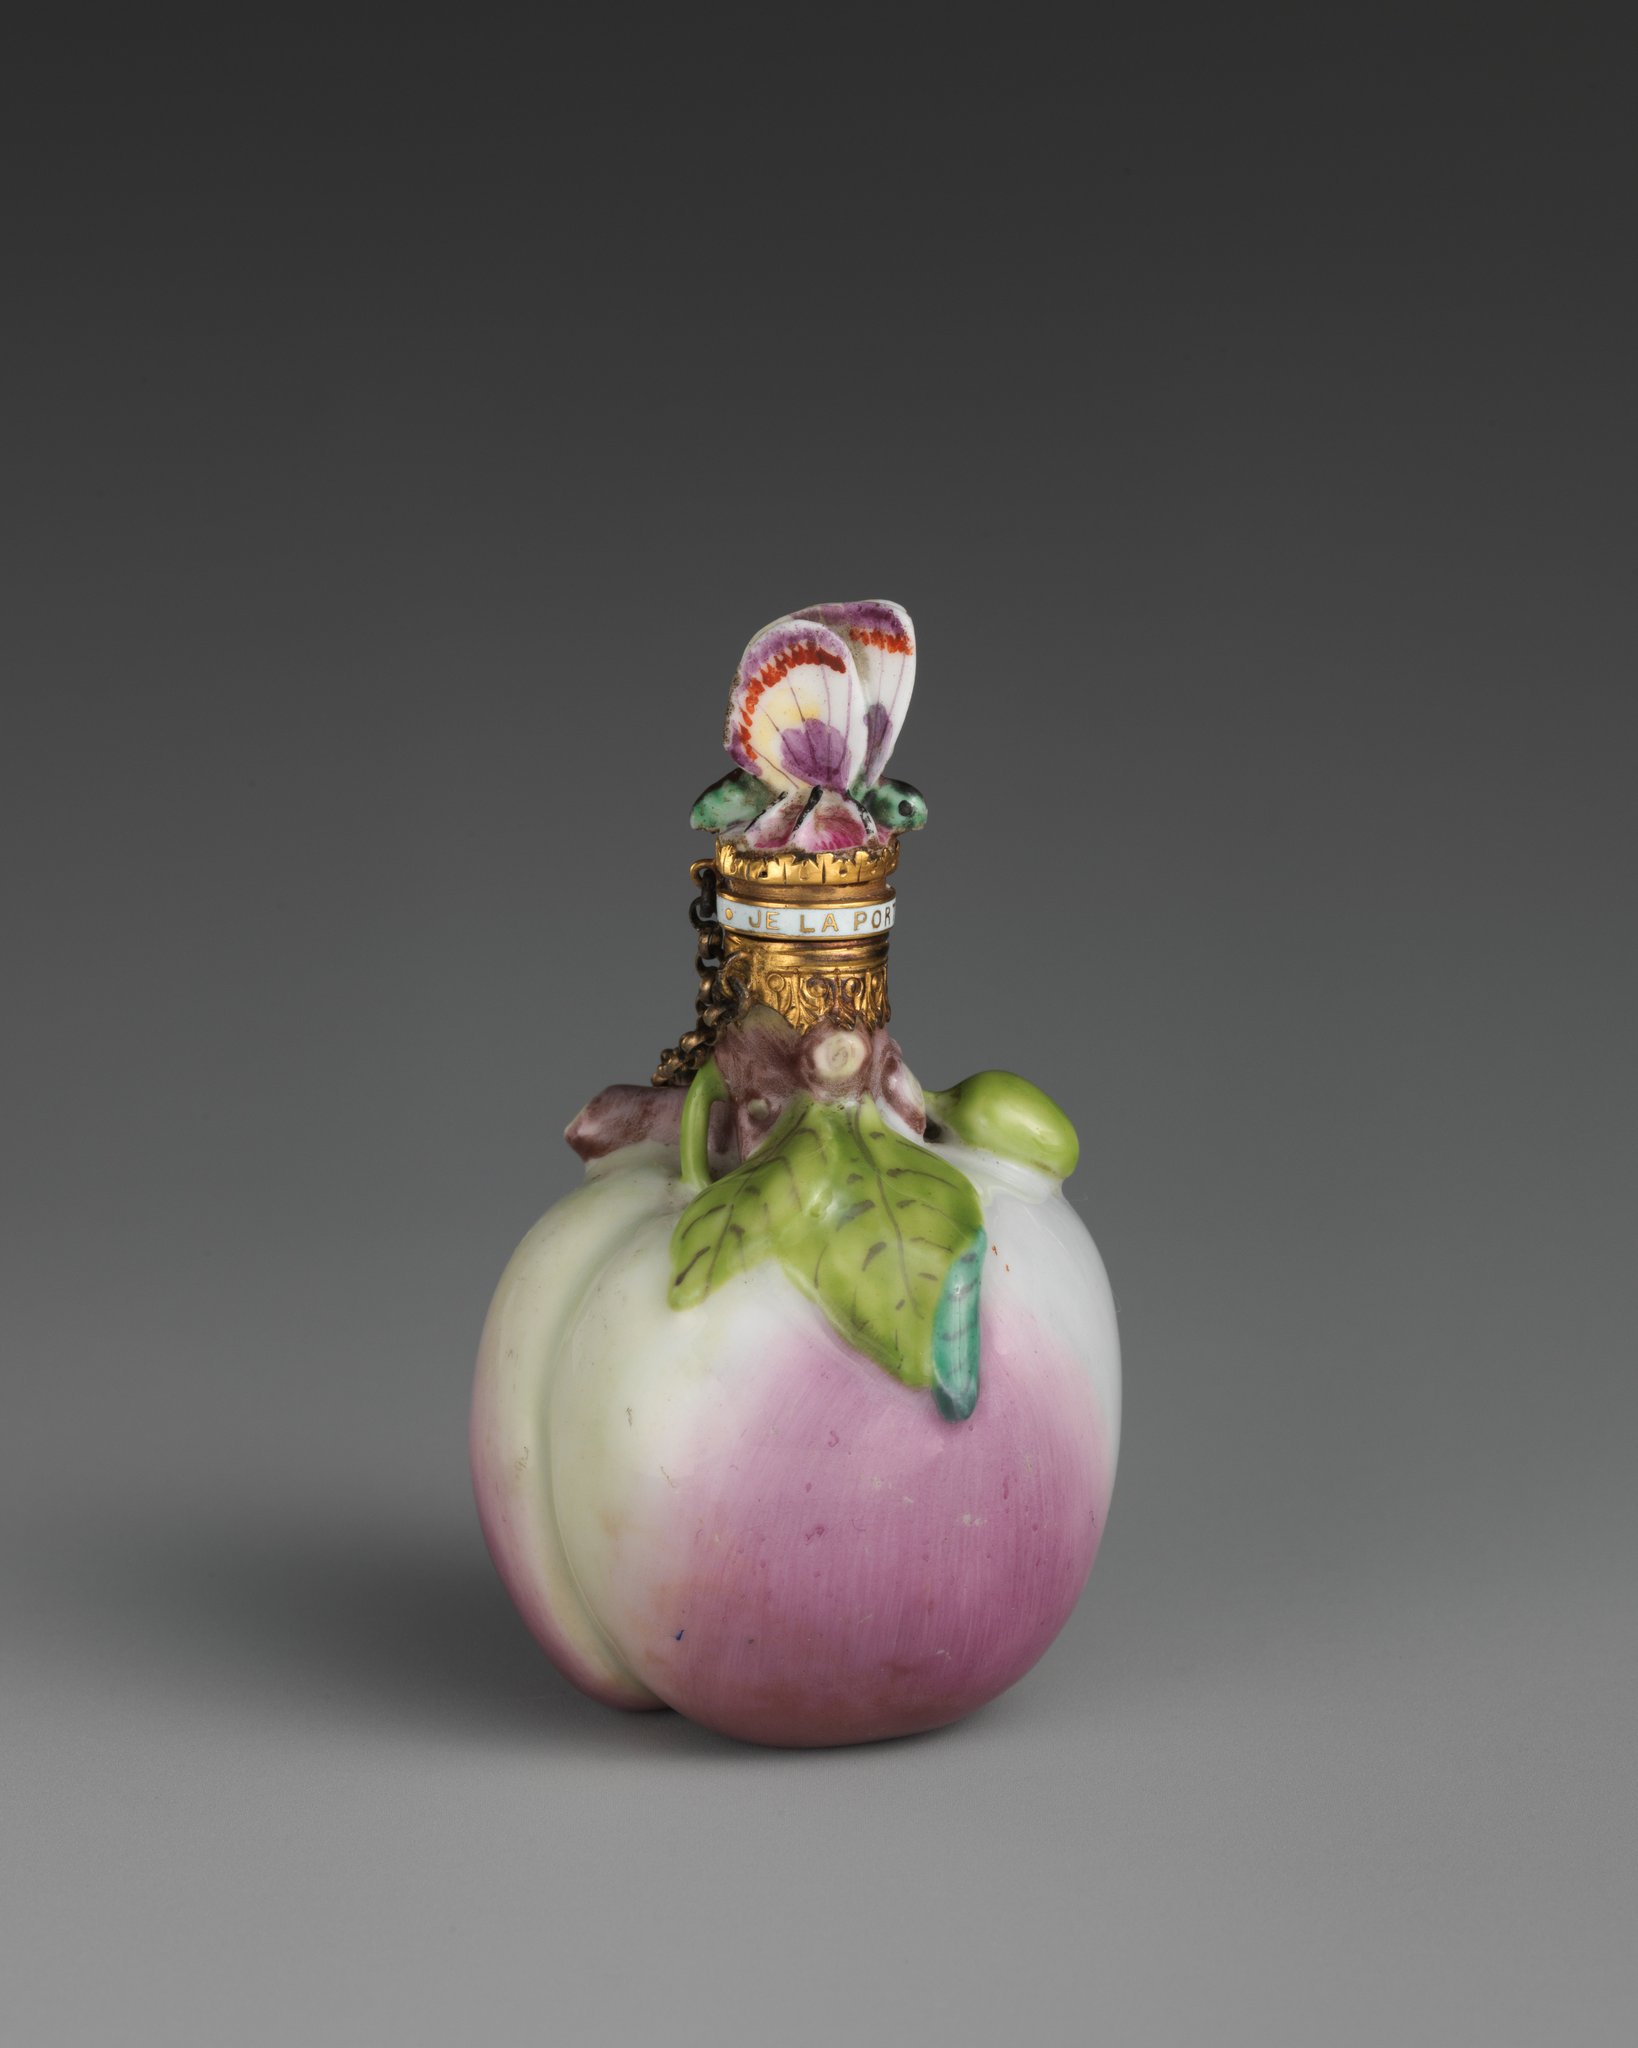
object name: scent bottle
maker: chelsea porcelain manufactory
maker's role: factory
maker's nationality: british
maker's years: 1744-1784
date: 1753-1758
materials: soft paste porcelain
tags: fruit,butterflies